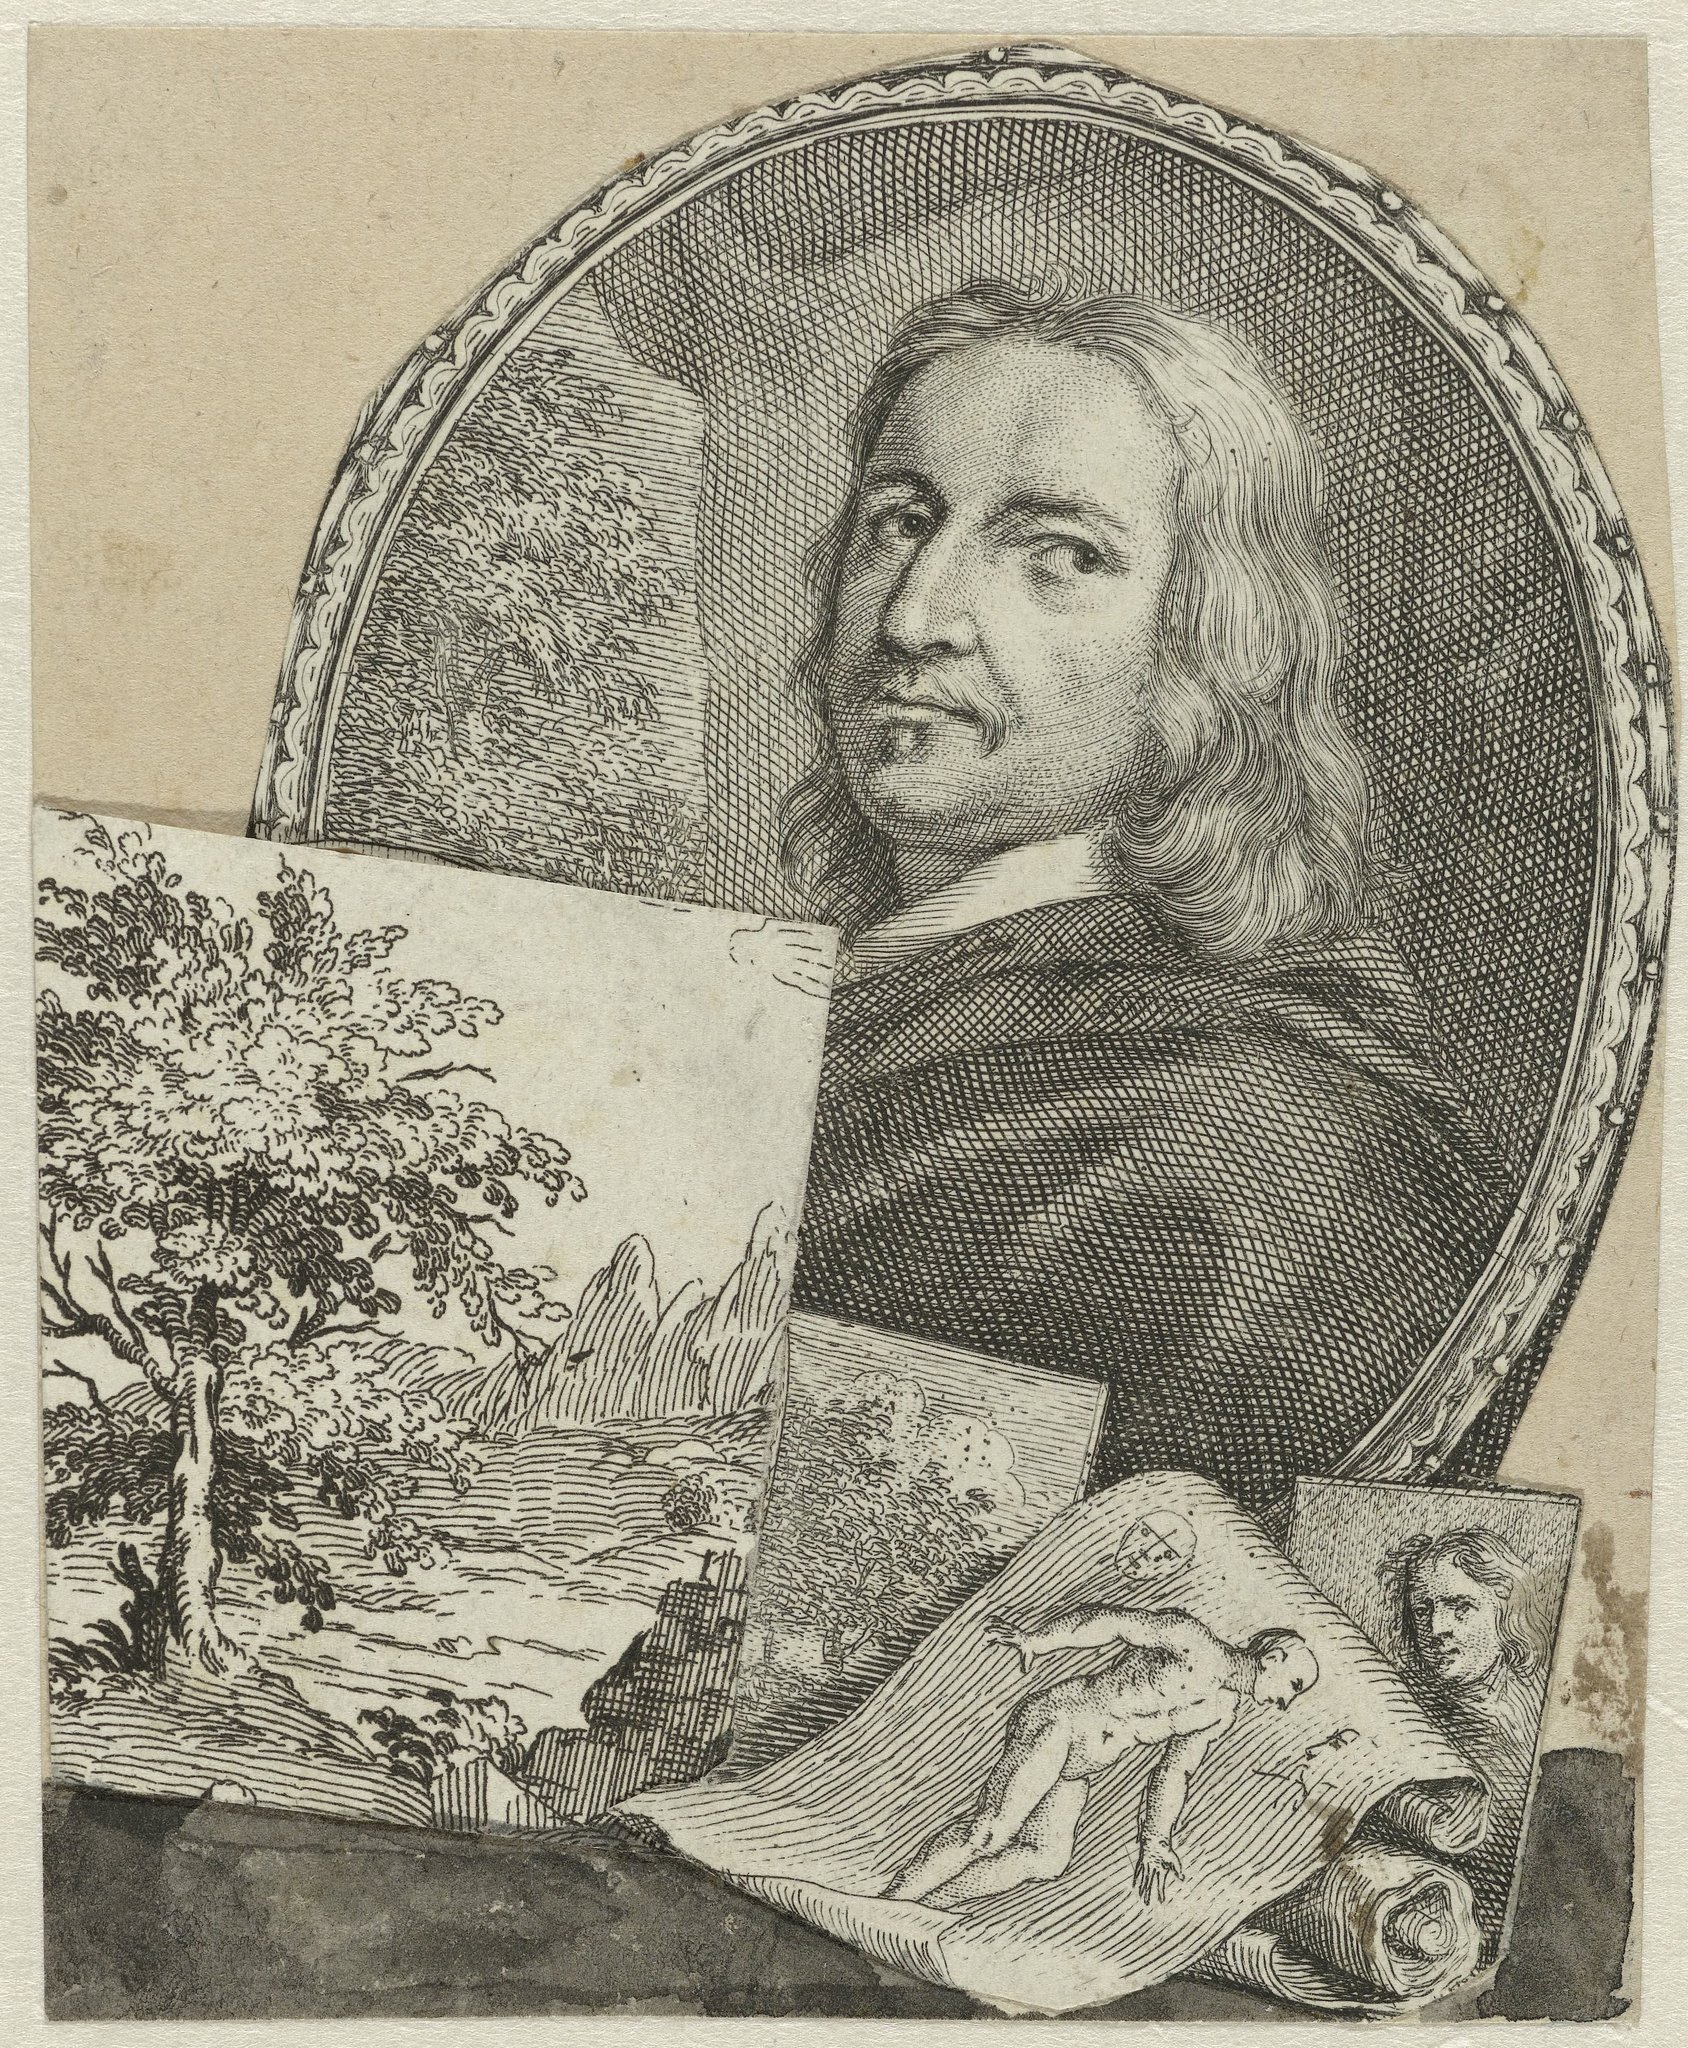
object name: print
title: Portret van Philippe de Champaigne in collage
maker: arnold houbraken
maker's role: draughtsman, painter, print maker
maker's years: 1660-1719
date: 1718-1721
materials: paper, watercolor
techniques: collage, engraving, etching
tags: brussels, paris, painter, draughtsman, philippe de champaigne, drawing, sketch, print, e.g.: engraving, etching, lithograph, portrait, self-portrait of artist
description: Medaillon met portret van Philippe de Champaigne geknipt uit de plaat met drie kunstenaarsportretten uit: Arnold Houbraken, De groote schouburgh, deel 1, tussen pagina 224 en 225. Behalve het portret van Champaigne zijn ook de drie afgebeelde vellen met tekeningen of prenten uitgeknipt en gemonteerd op een apart klein vel papier. Hierop is verder een deel van een kleine landschapsets geplakt en een onderste zone in grijze waterverf aangebracht met penseel.